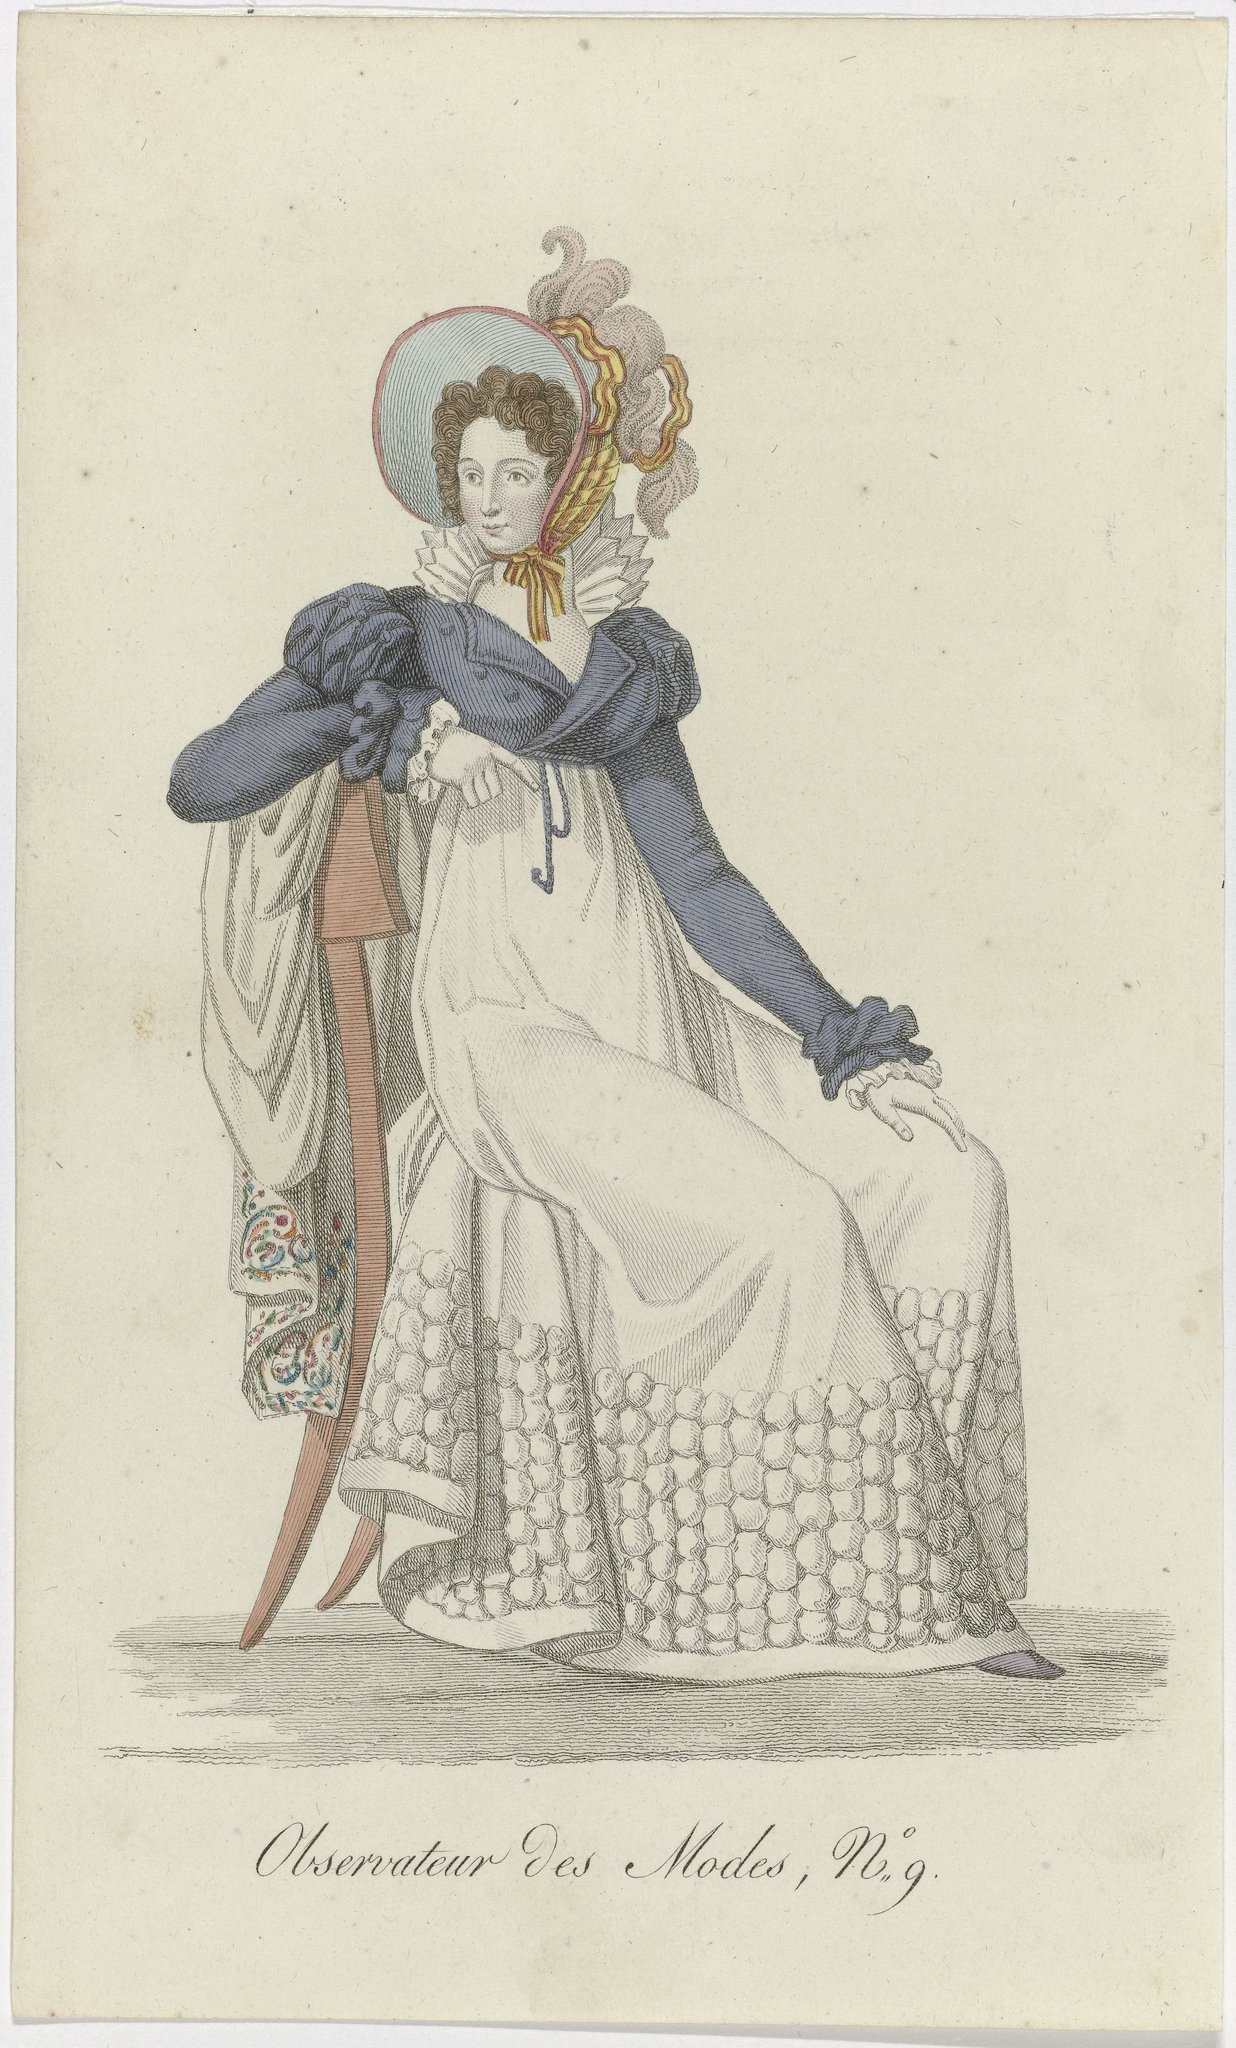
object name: fashion print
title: Observateur des Modes, 1818-1823, No. 9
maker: Anonymous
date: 1818-1823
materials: paper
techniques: engraving, etching, hand coloring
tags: clothing for the upper part of the body (shawl) (+ women's clothes), clothing for the upper part of the body (spencer) (+ women's clothes), fashion plates, dress, gown (+ women's clothes), neck-gear ~ clothing (+ women's clothes)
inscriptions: title: ‘Observateur des Modes, No"9’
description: Vrouw, zittend op een stoel, gekleed in een spencer en japon. Dubbele kraag met gekartelde zoom. Luifelhoed. Sjaal. Prent uit het modetijdschrift Observateur des Modes (août 1818 - 30 novembre 1823).